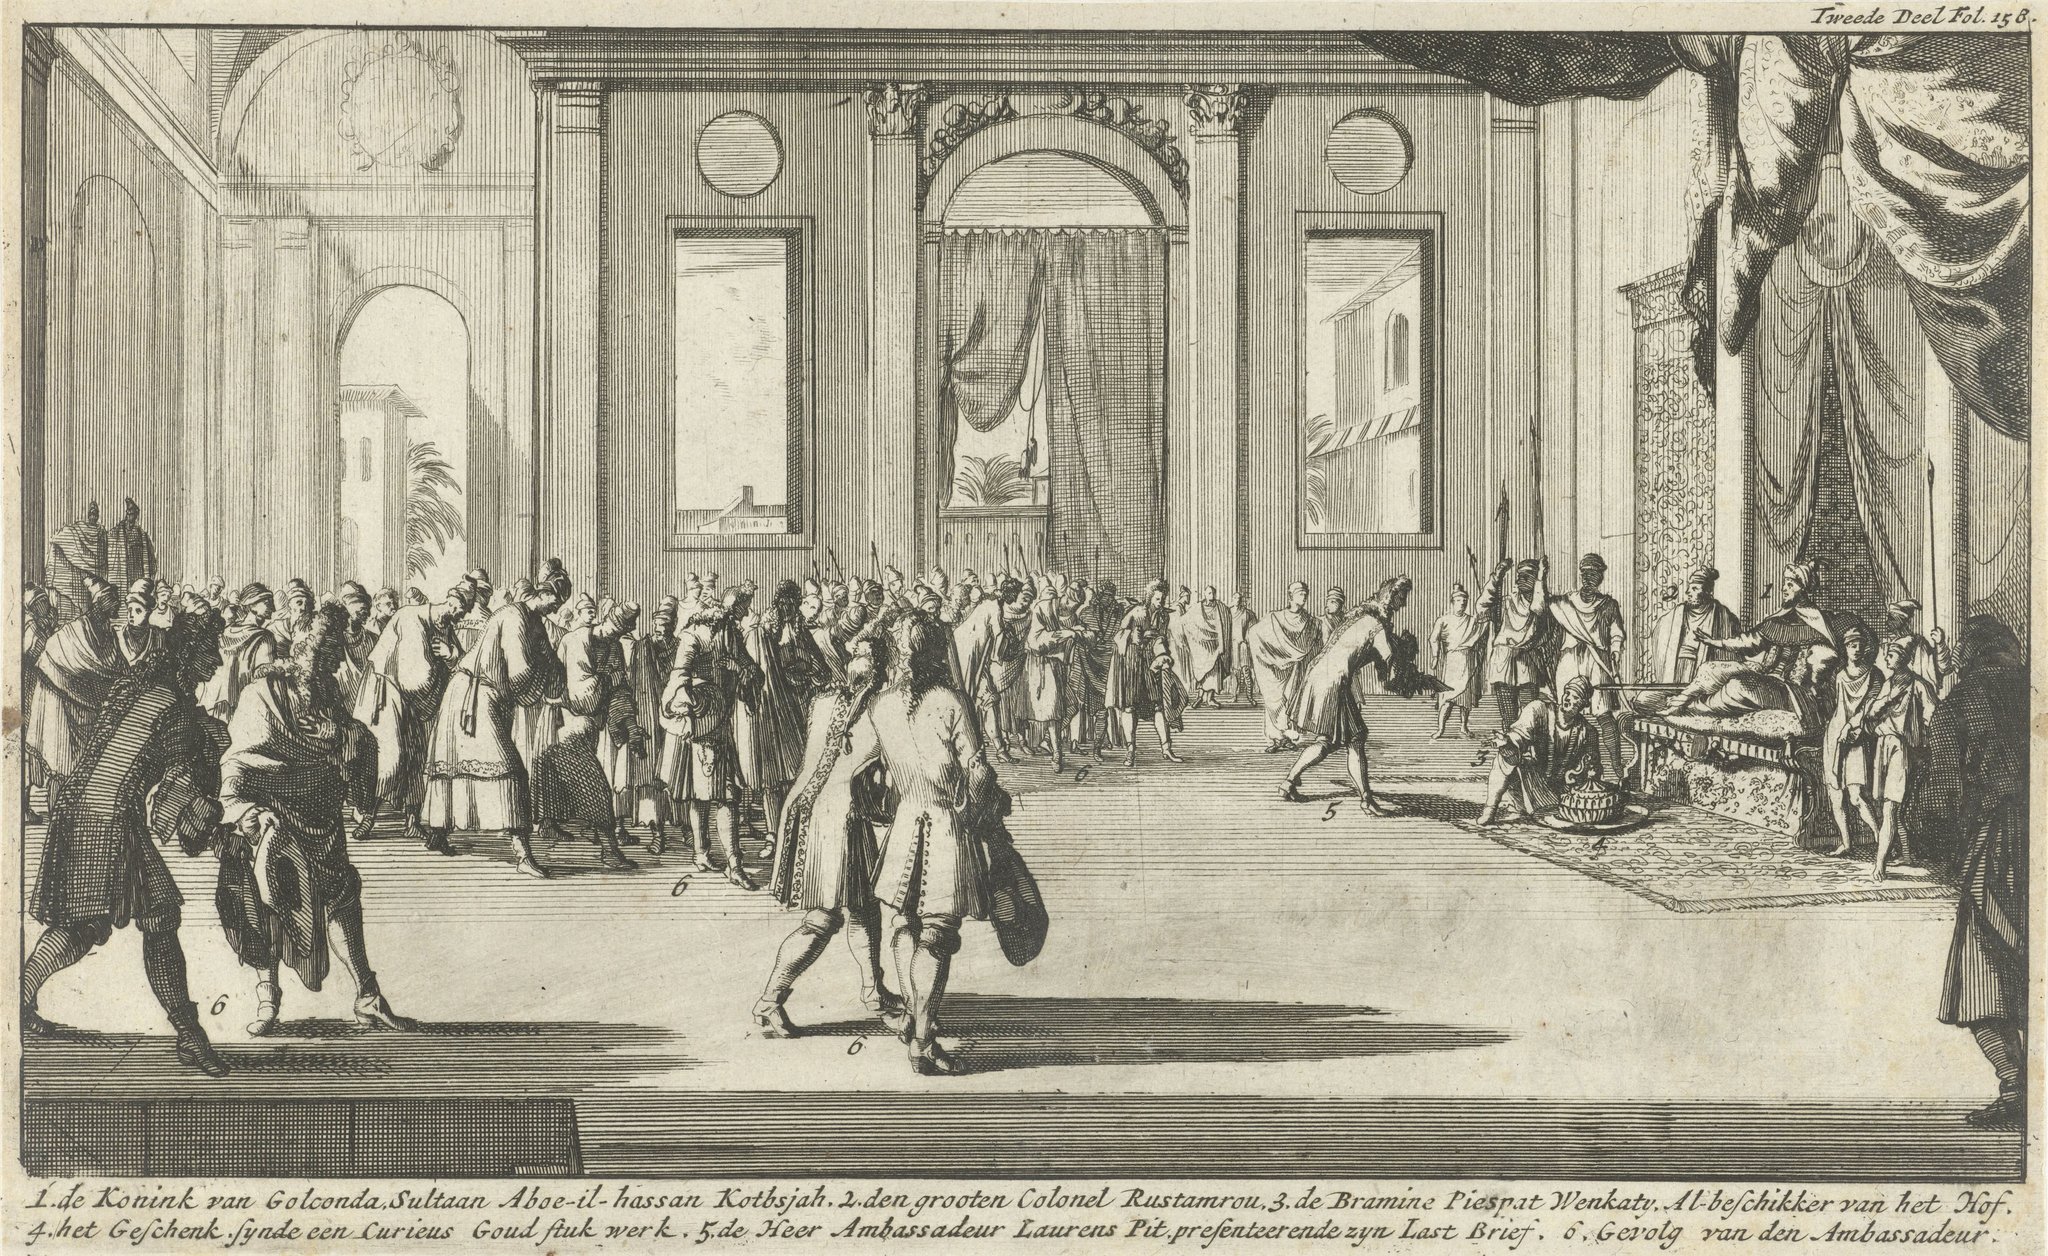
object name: book illustration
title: Laurens Pit bezoekt sultan Abul Hasan Qutb Shah in Golkonda om hem een lastbrief te overhandigen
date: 1693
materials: paper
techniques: etching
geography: amsterdam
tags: ruler, sovereign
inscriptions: collector's mark: Lugt 2228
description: Illustratie uit: Havart, Daniël. Op- en ondergang van Cormandel, 2 delen. Amsterdam: Jan Claesz ten Hoorn, 1693.